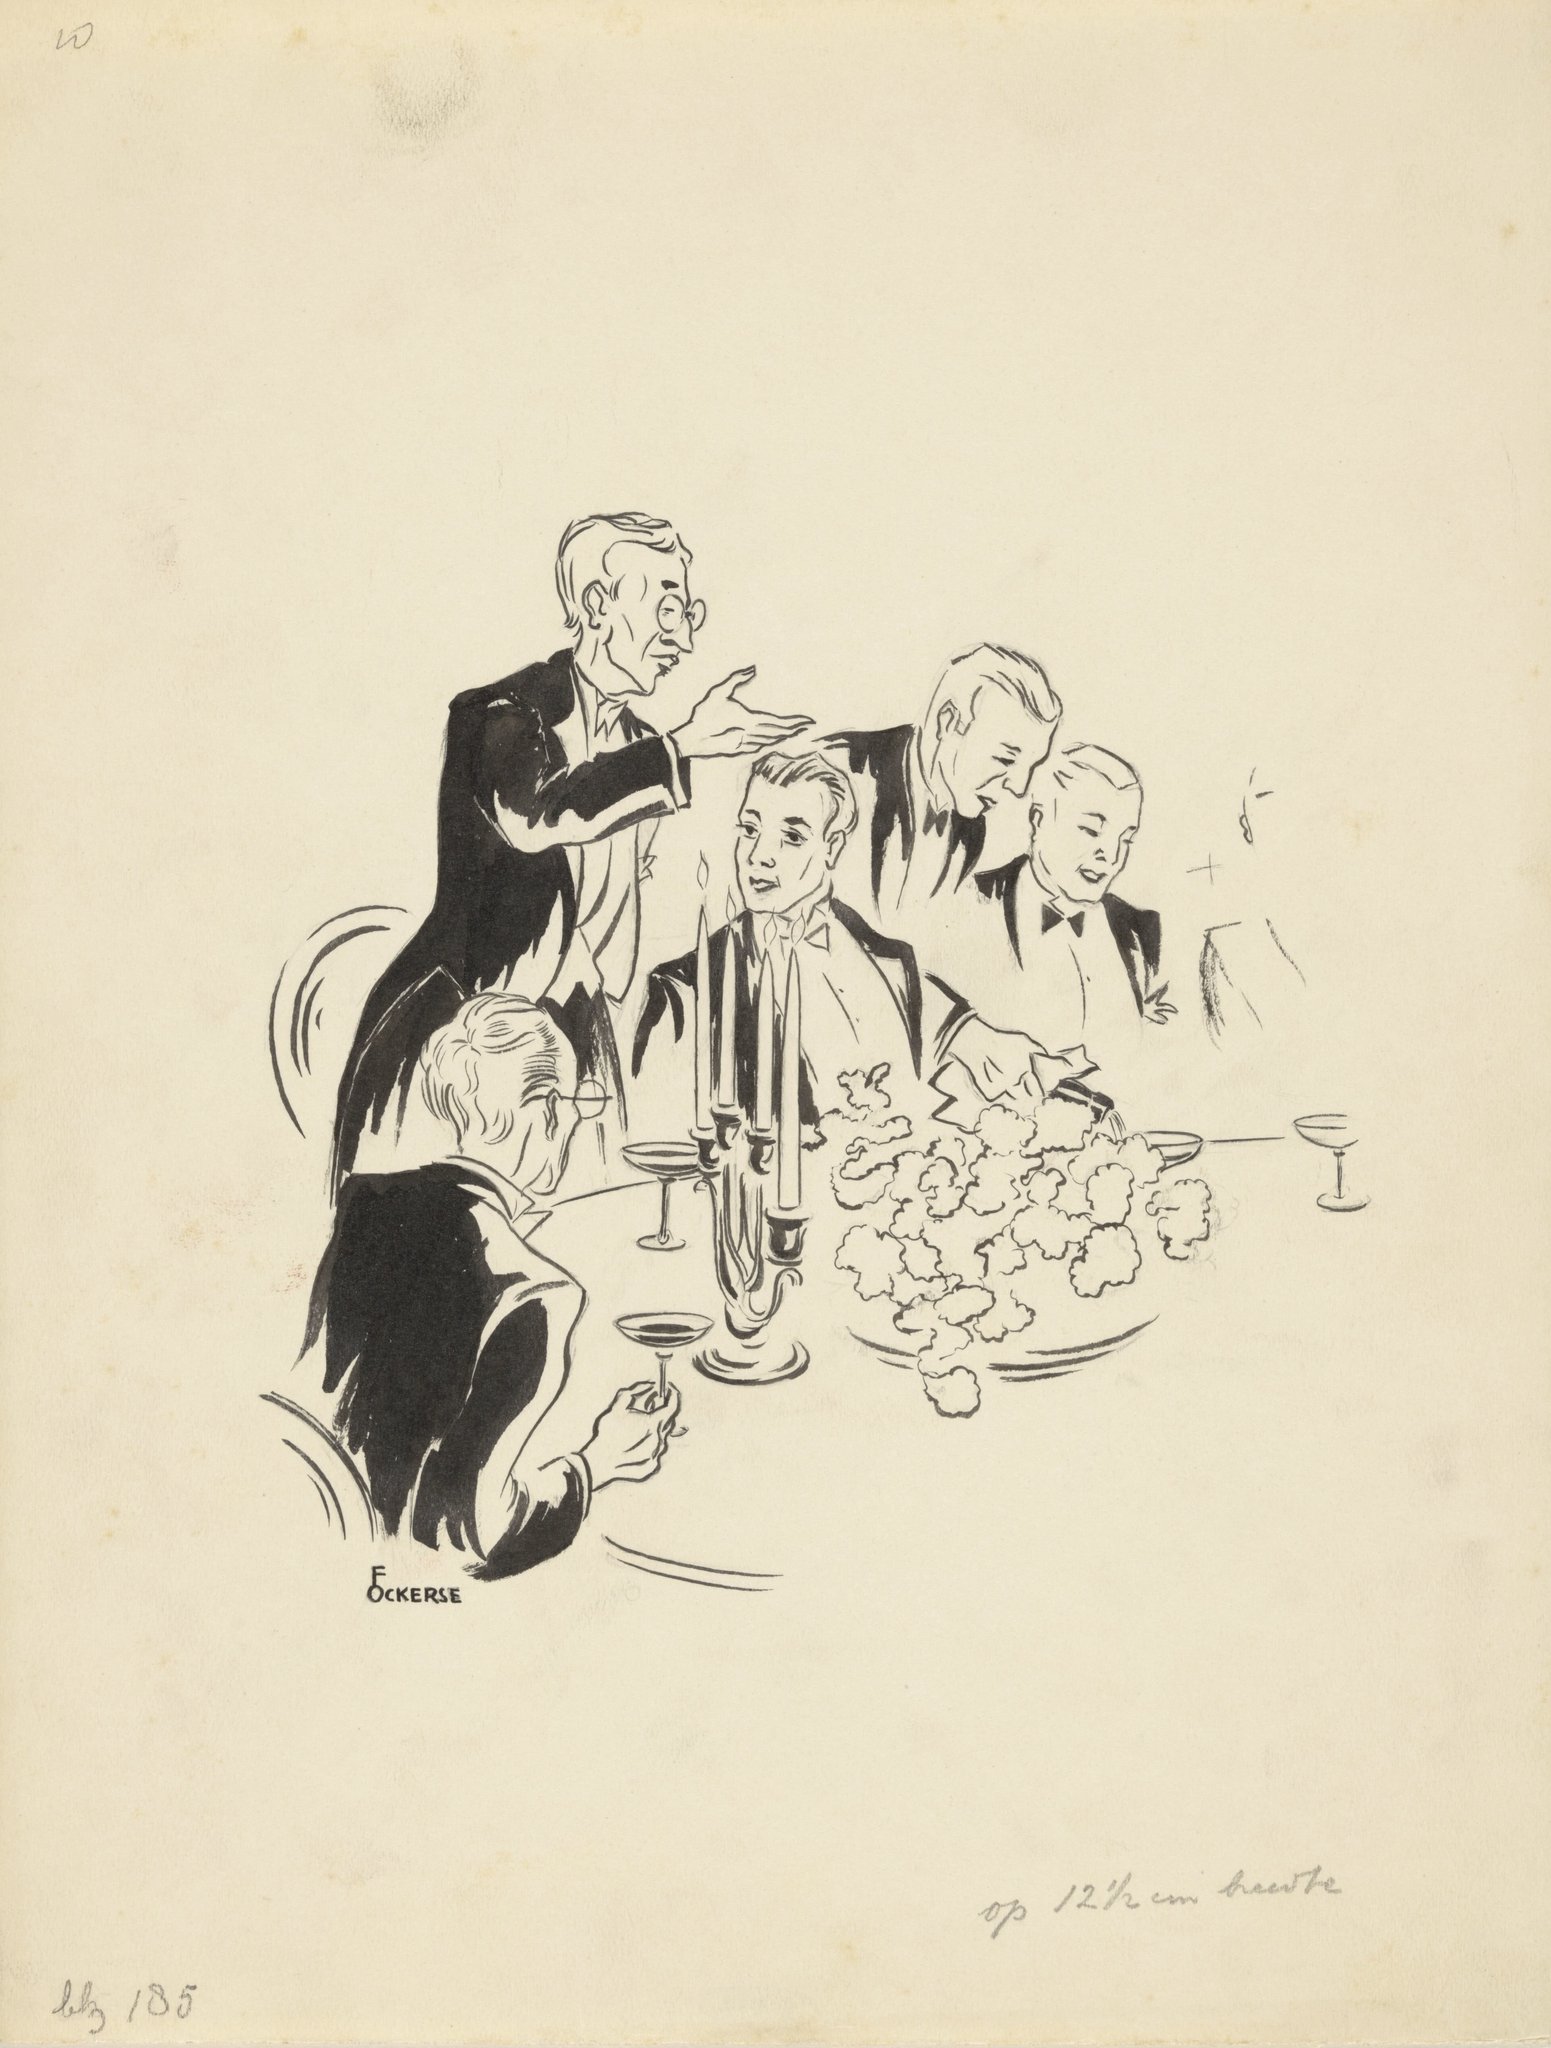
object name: boekillustratie ontwerp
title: Man geeft een speech bij een diner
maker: f. ockerse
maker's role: draughtsman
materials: paint, paper, pencil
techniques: brush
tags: dress, gown: dinner dress, evening meal, dinner, supper, person addressing a group, orator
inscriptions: annotation: ‘10/ blz 185’, :, signature: ‘F/ OCKERSE’, collector's mark: Lugt 2228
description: Vier mannen zitten in avondkleding aan een tafel. Op tafel staan wijnglazen en een kandelaar. Eén man staat en spreekt het gezelschap toe.